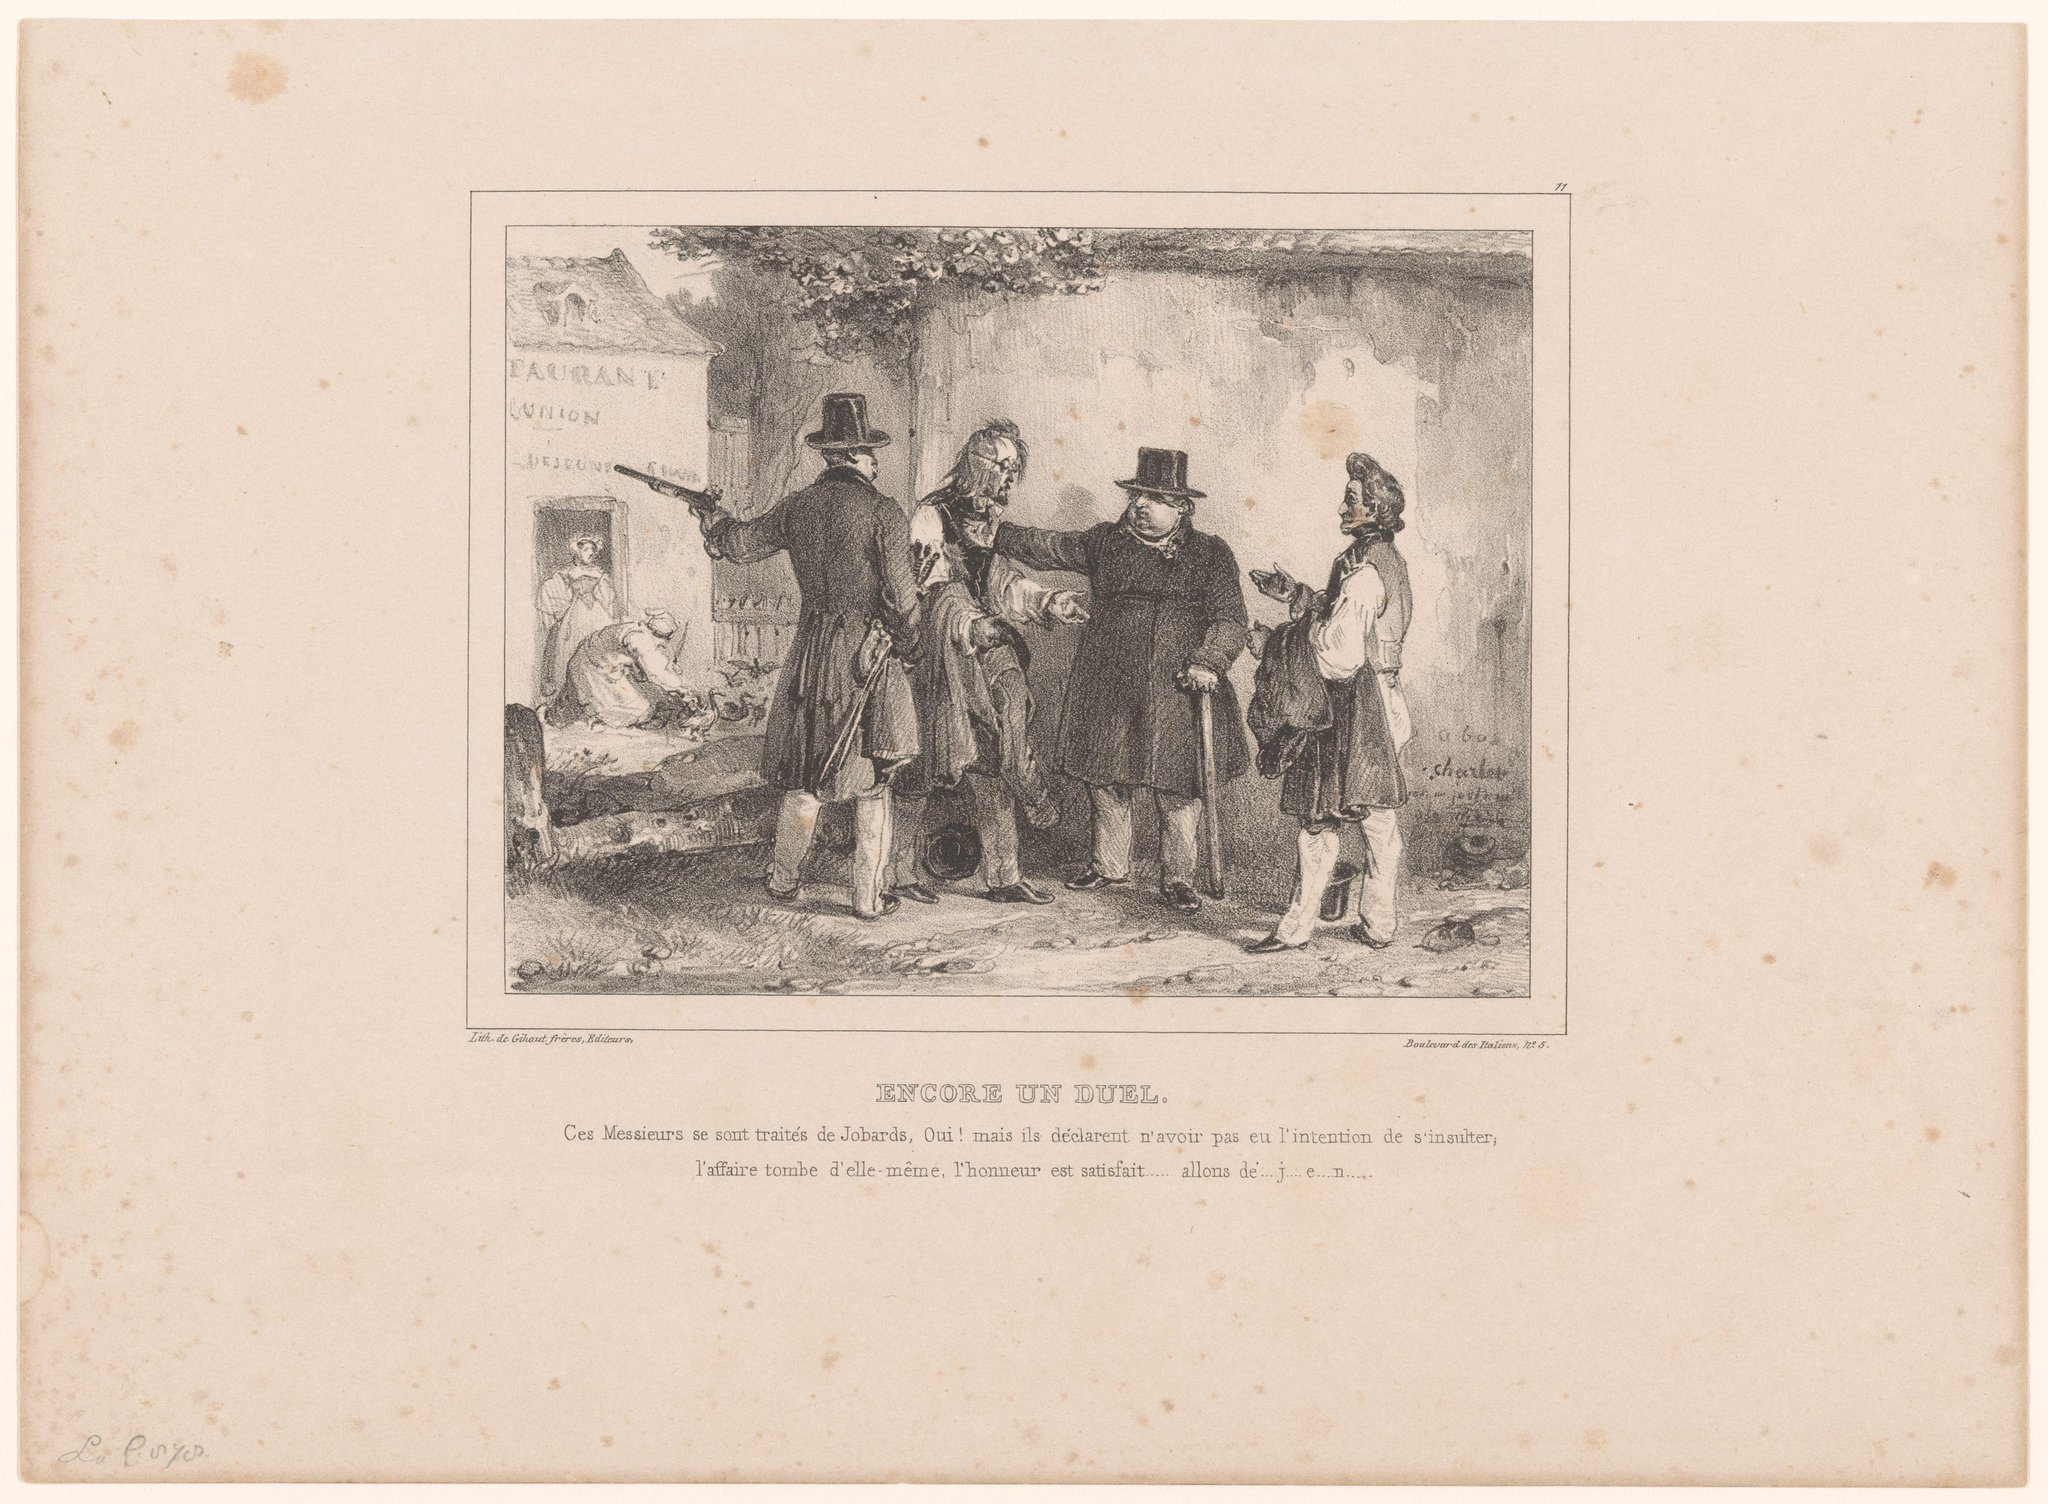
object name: print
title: Twee mannen bereiden zich voor op een duel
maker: nicolas toussaint charlet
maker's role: draughtsman, painter, print maker, printer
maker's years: 1792-1845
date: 1836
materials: paper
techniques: lithograph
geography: paris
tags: duelling, hotel, hostelry, inn, witnesses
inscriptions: collector's mark: Lugt 2228a